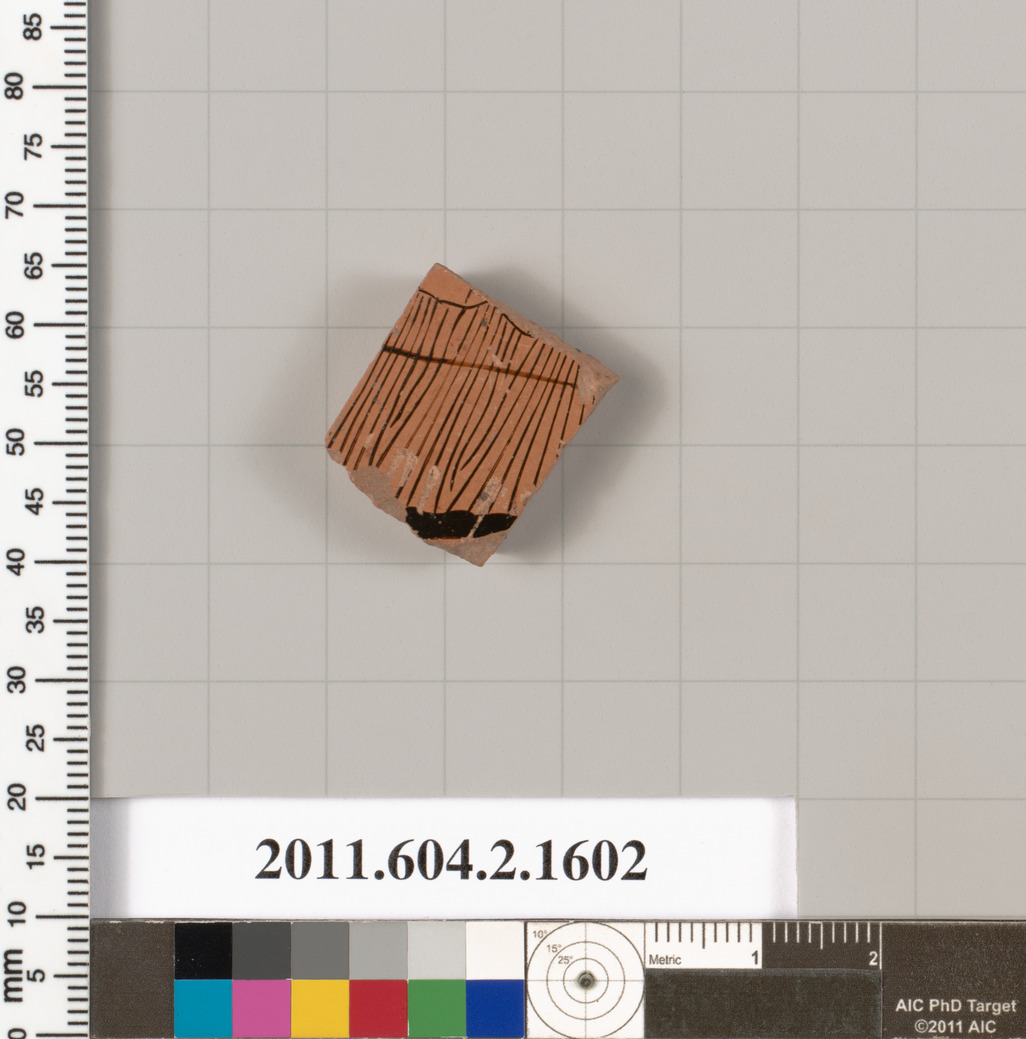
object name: skyphos fragment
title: Terracotta fragment of a skyphos (deep drinking cup)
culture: greek, attic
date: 460-440 BCE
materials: terracotta